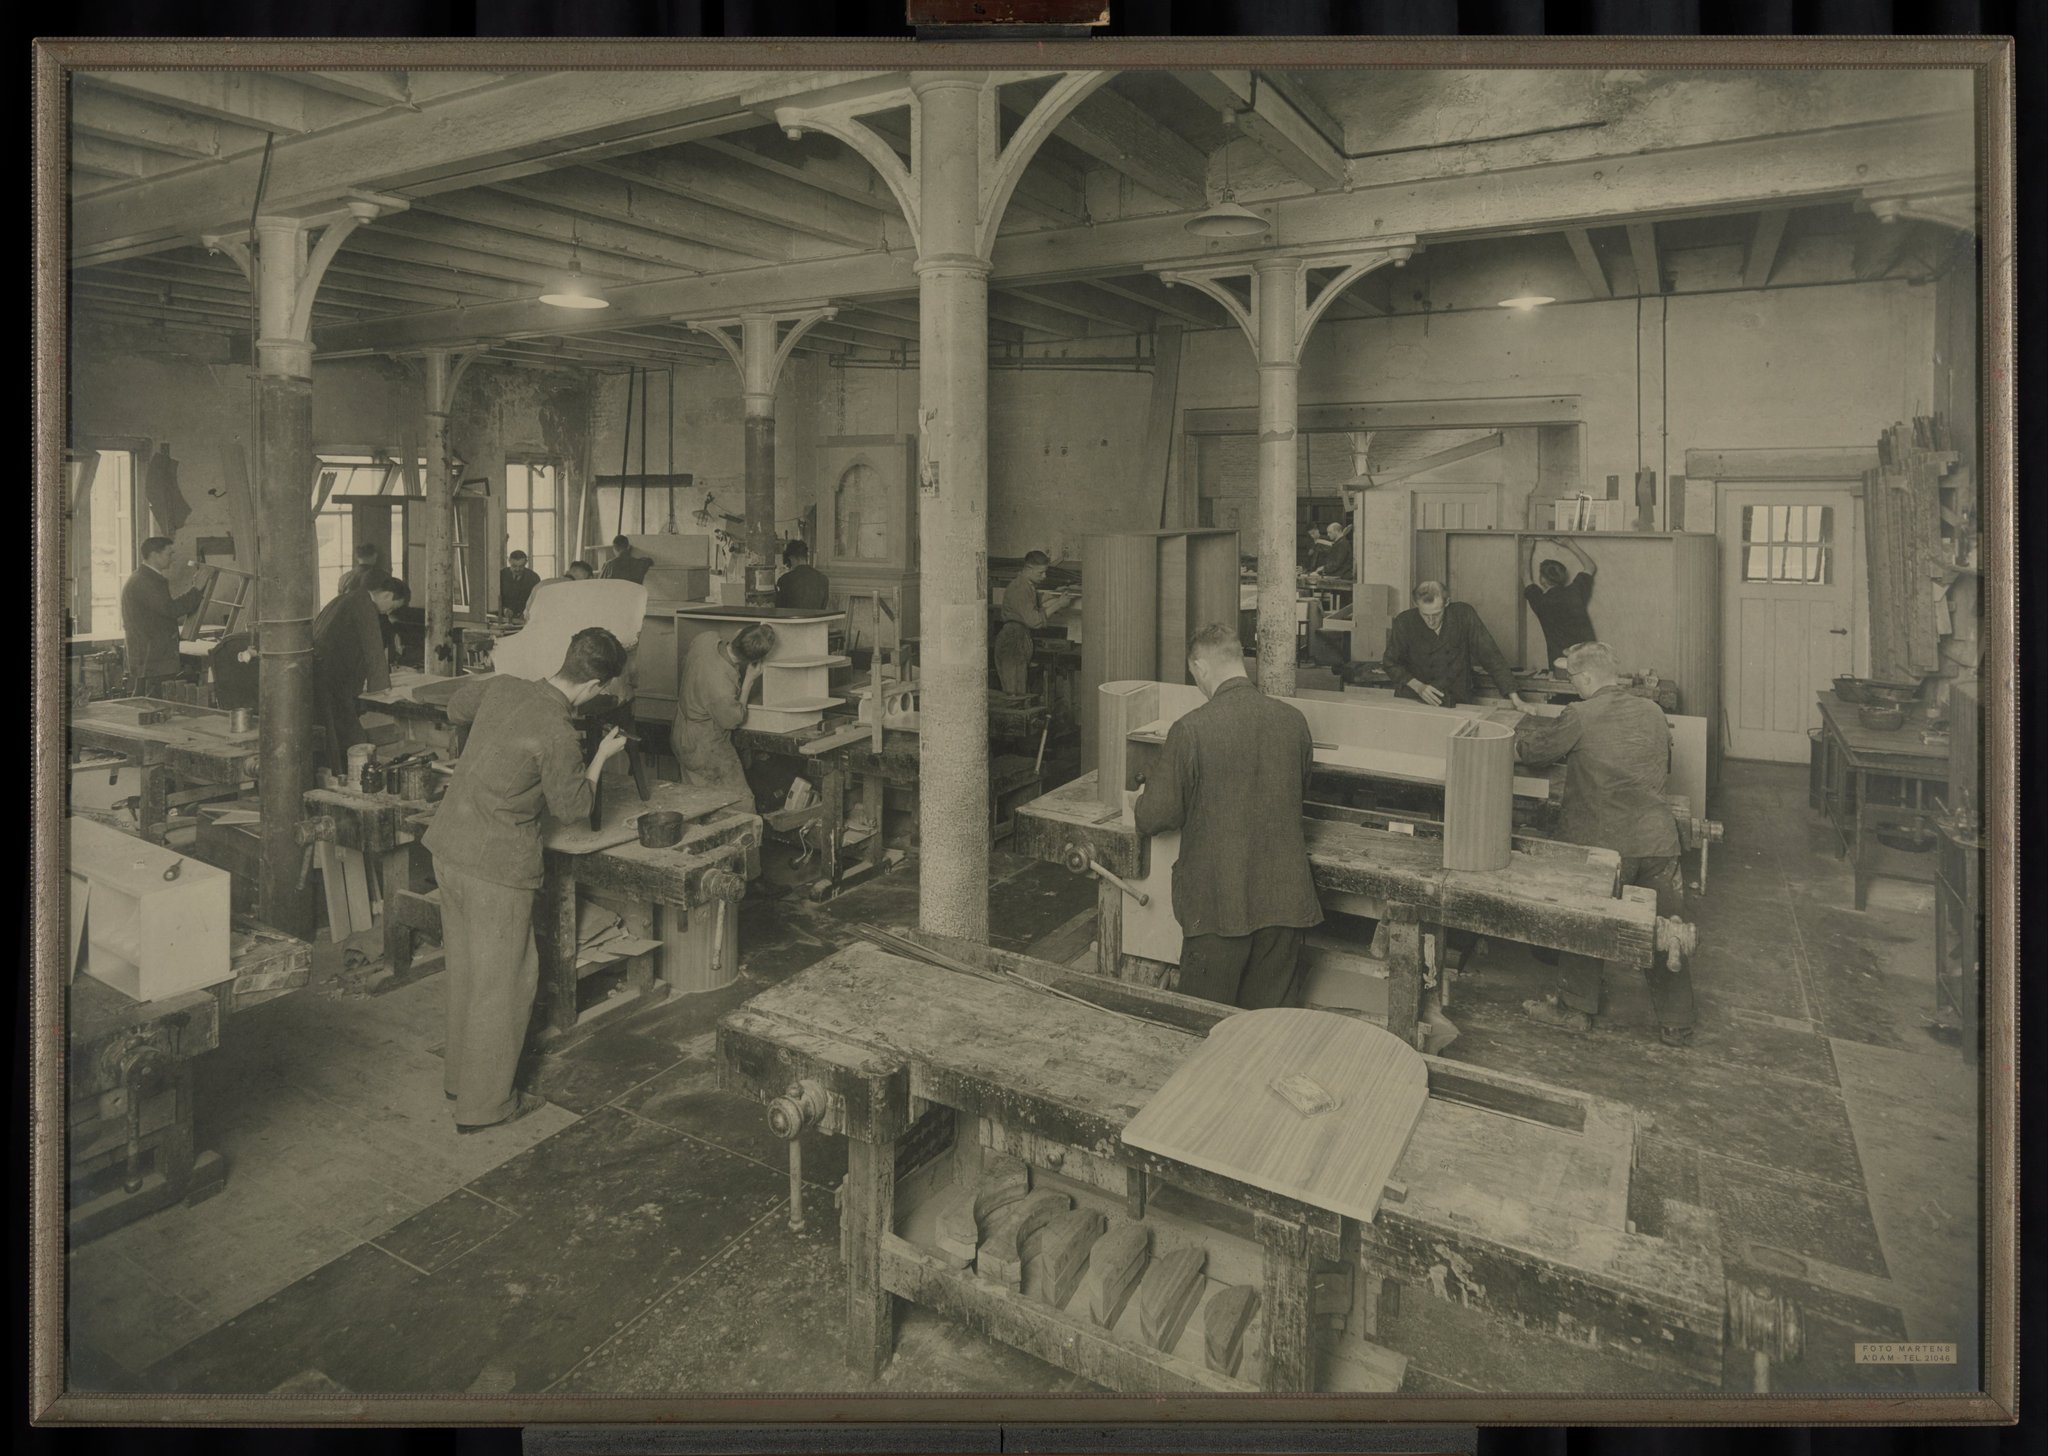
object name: photograph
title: werkplaats (fabriek) van 't Woonhuys, Amsterdam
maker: martens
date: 1925-1940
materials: cardboard, glass, photographic support, wood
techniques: gelatin silver print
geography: amsterdam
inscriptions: label: ‘FOTO MARTENS / A'DAM - TEL. 21046’